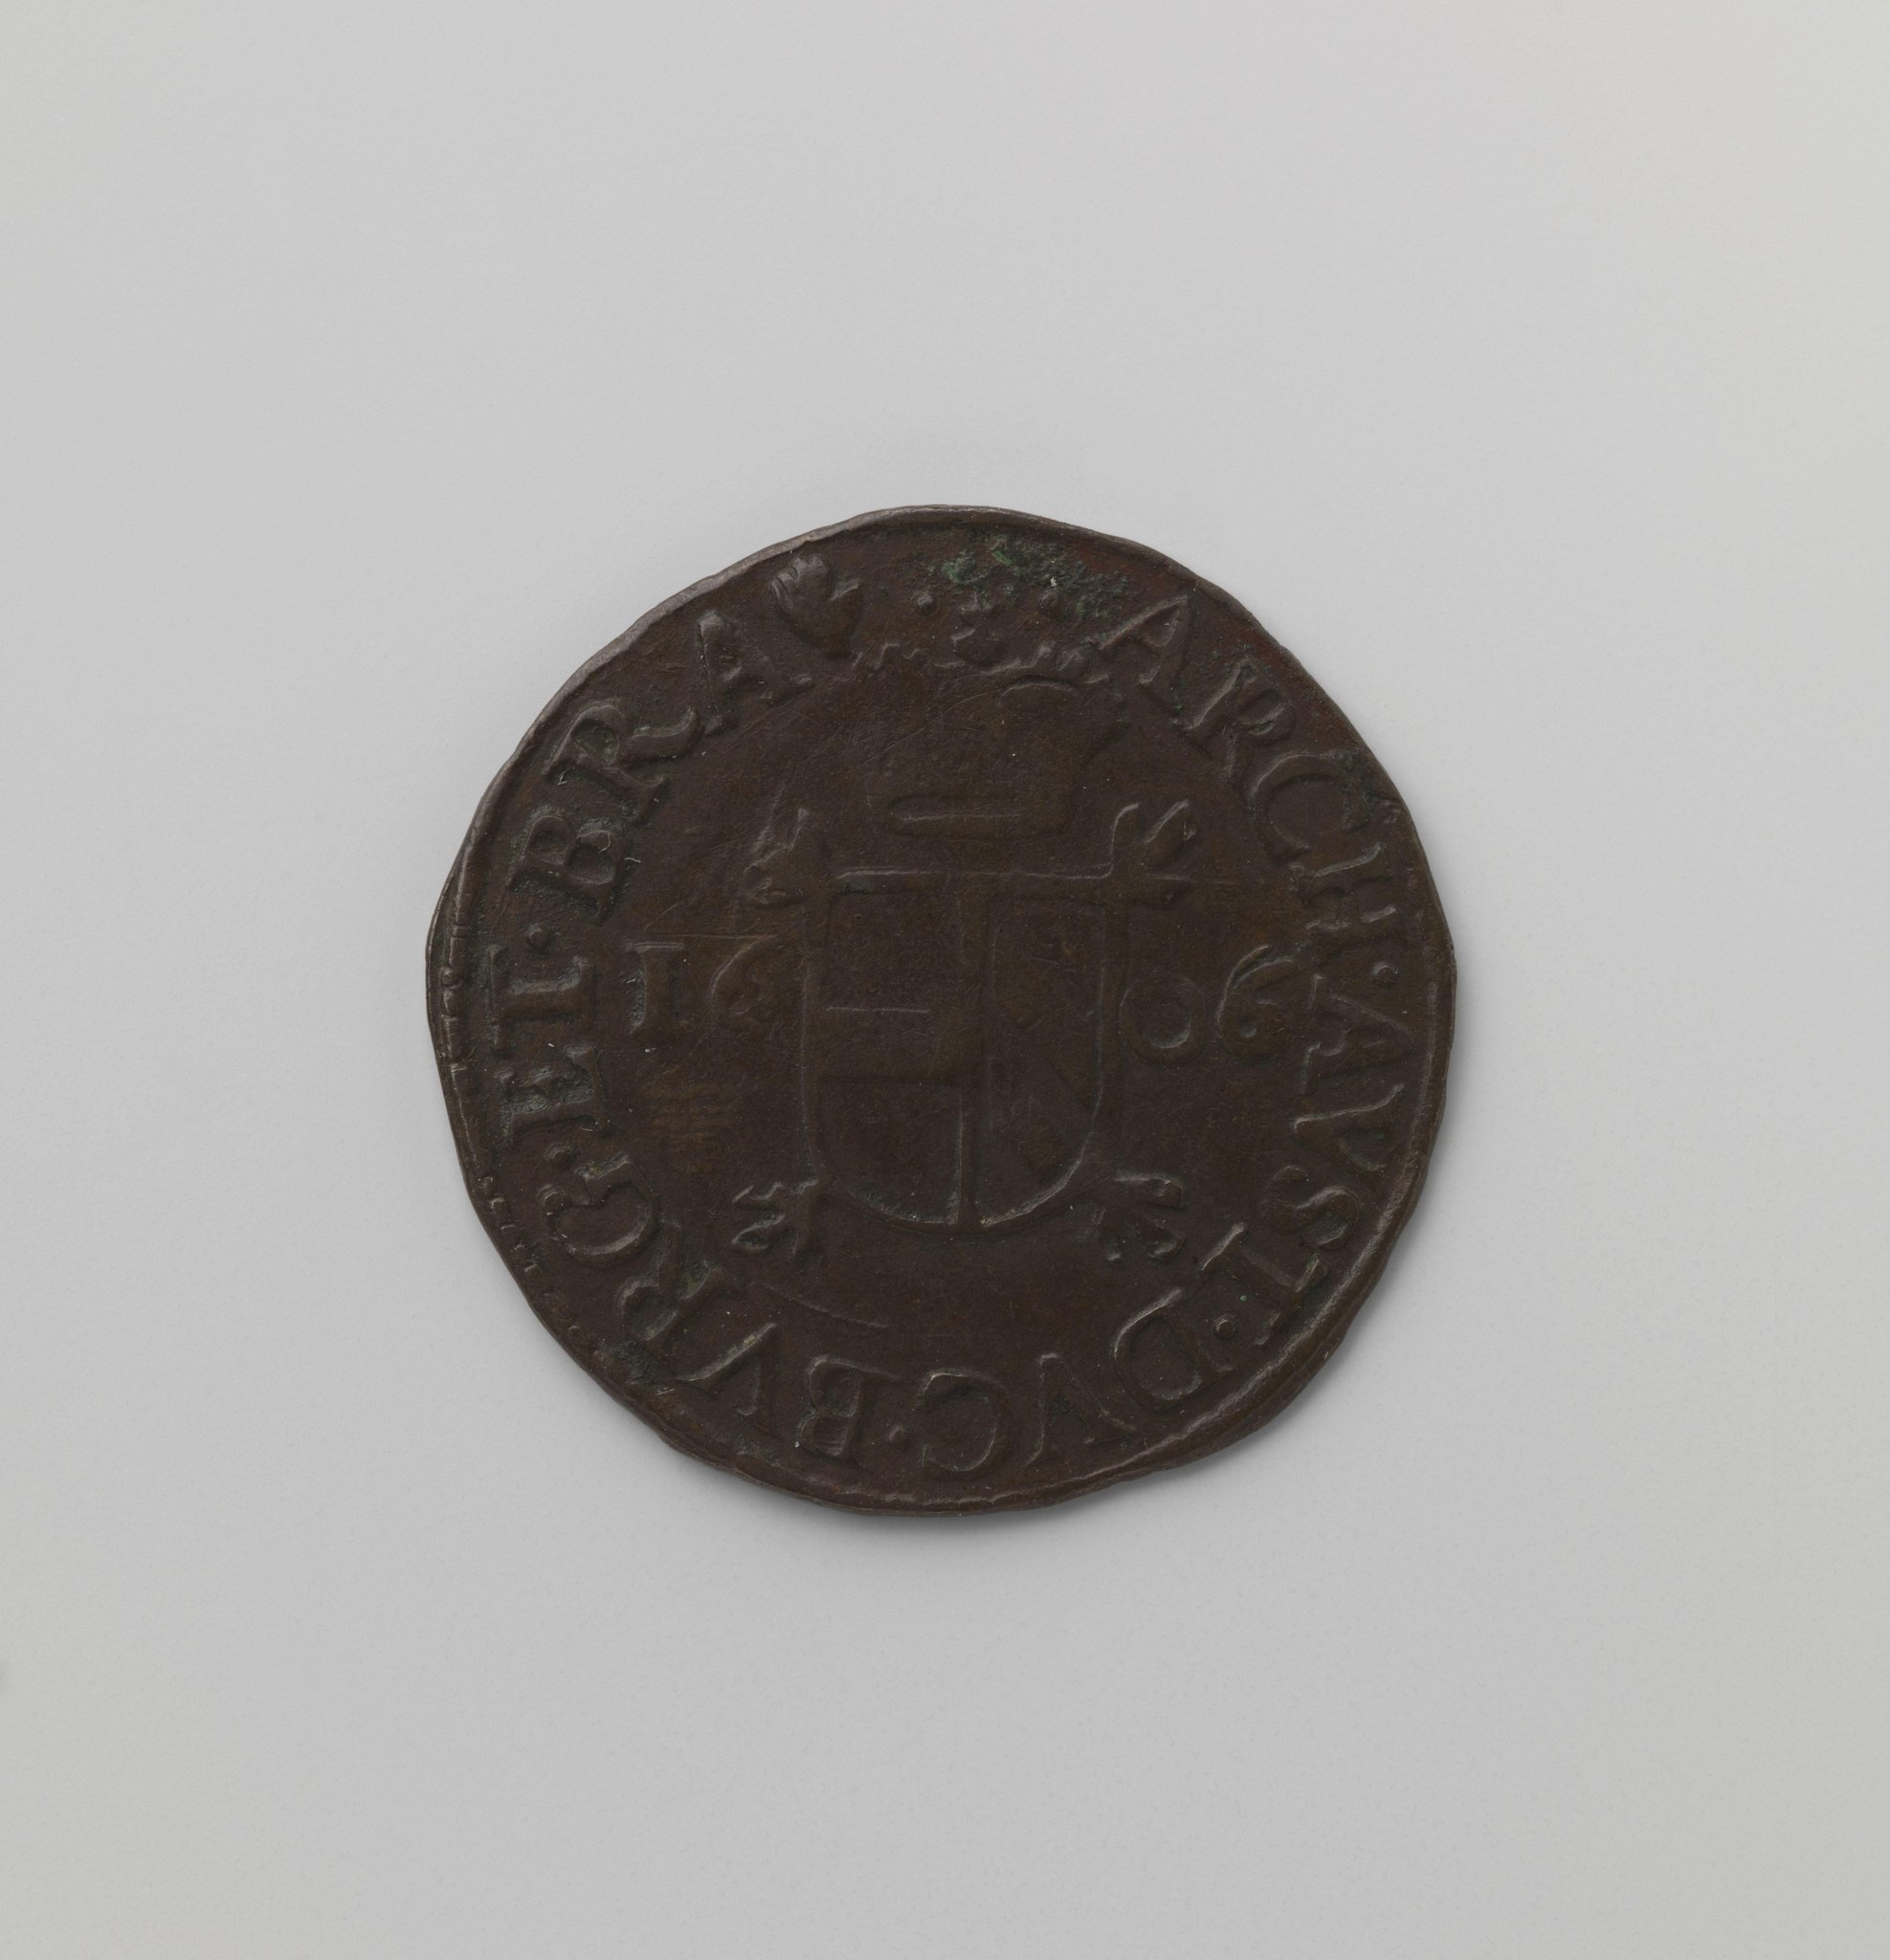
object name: coin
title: Dubbele penning uit Brabant van Albert en Isabella, 1606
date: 1606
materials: copper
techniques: striking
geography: antwerp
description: Koperen munt. Voorzijde: onder kroon verbonden letters A en E. Boven kroon hand. Keerzijde: tussen jaartal gekroond samengesteld wapenschild op stokkenkruis. Aan het eind van het omschrift hand.